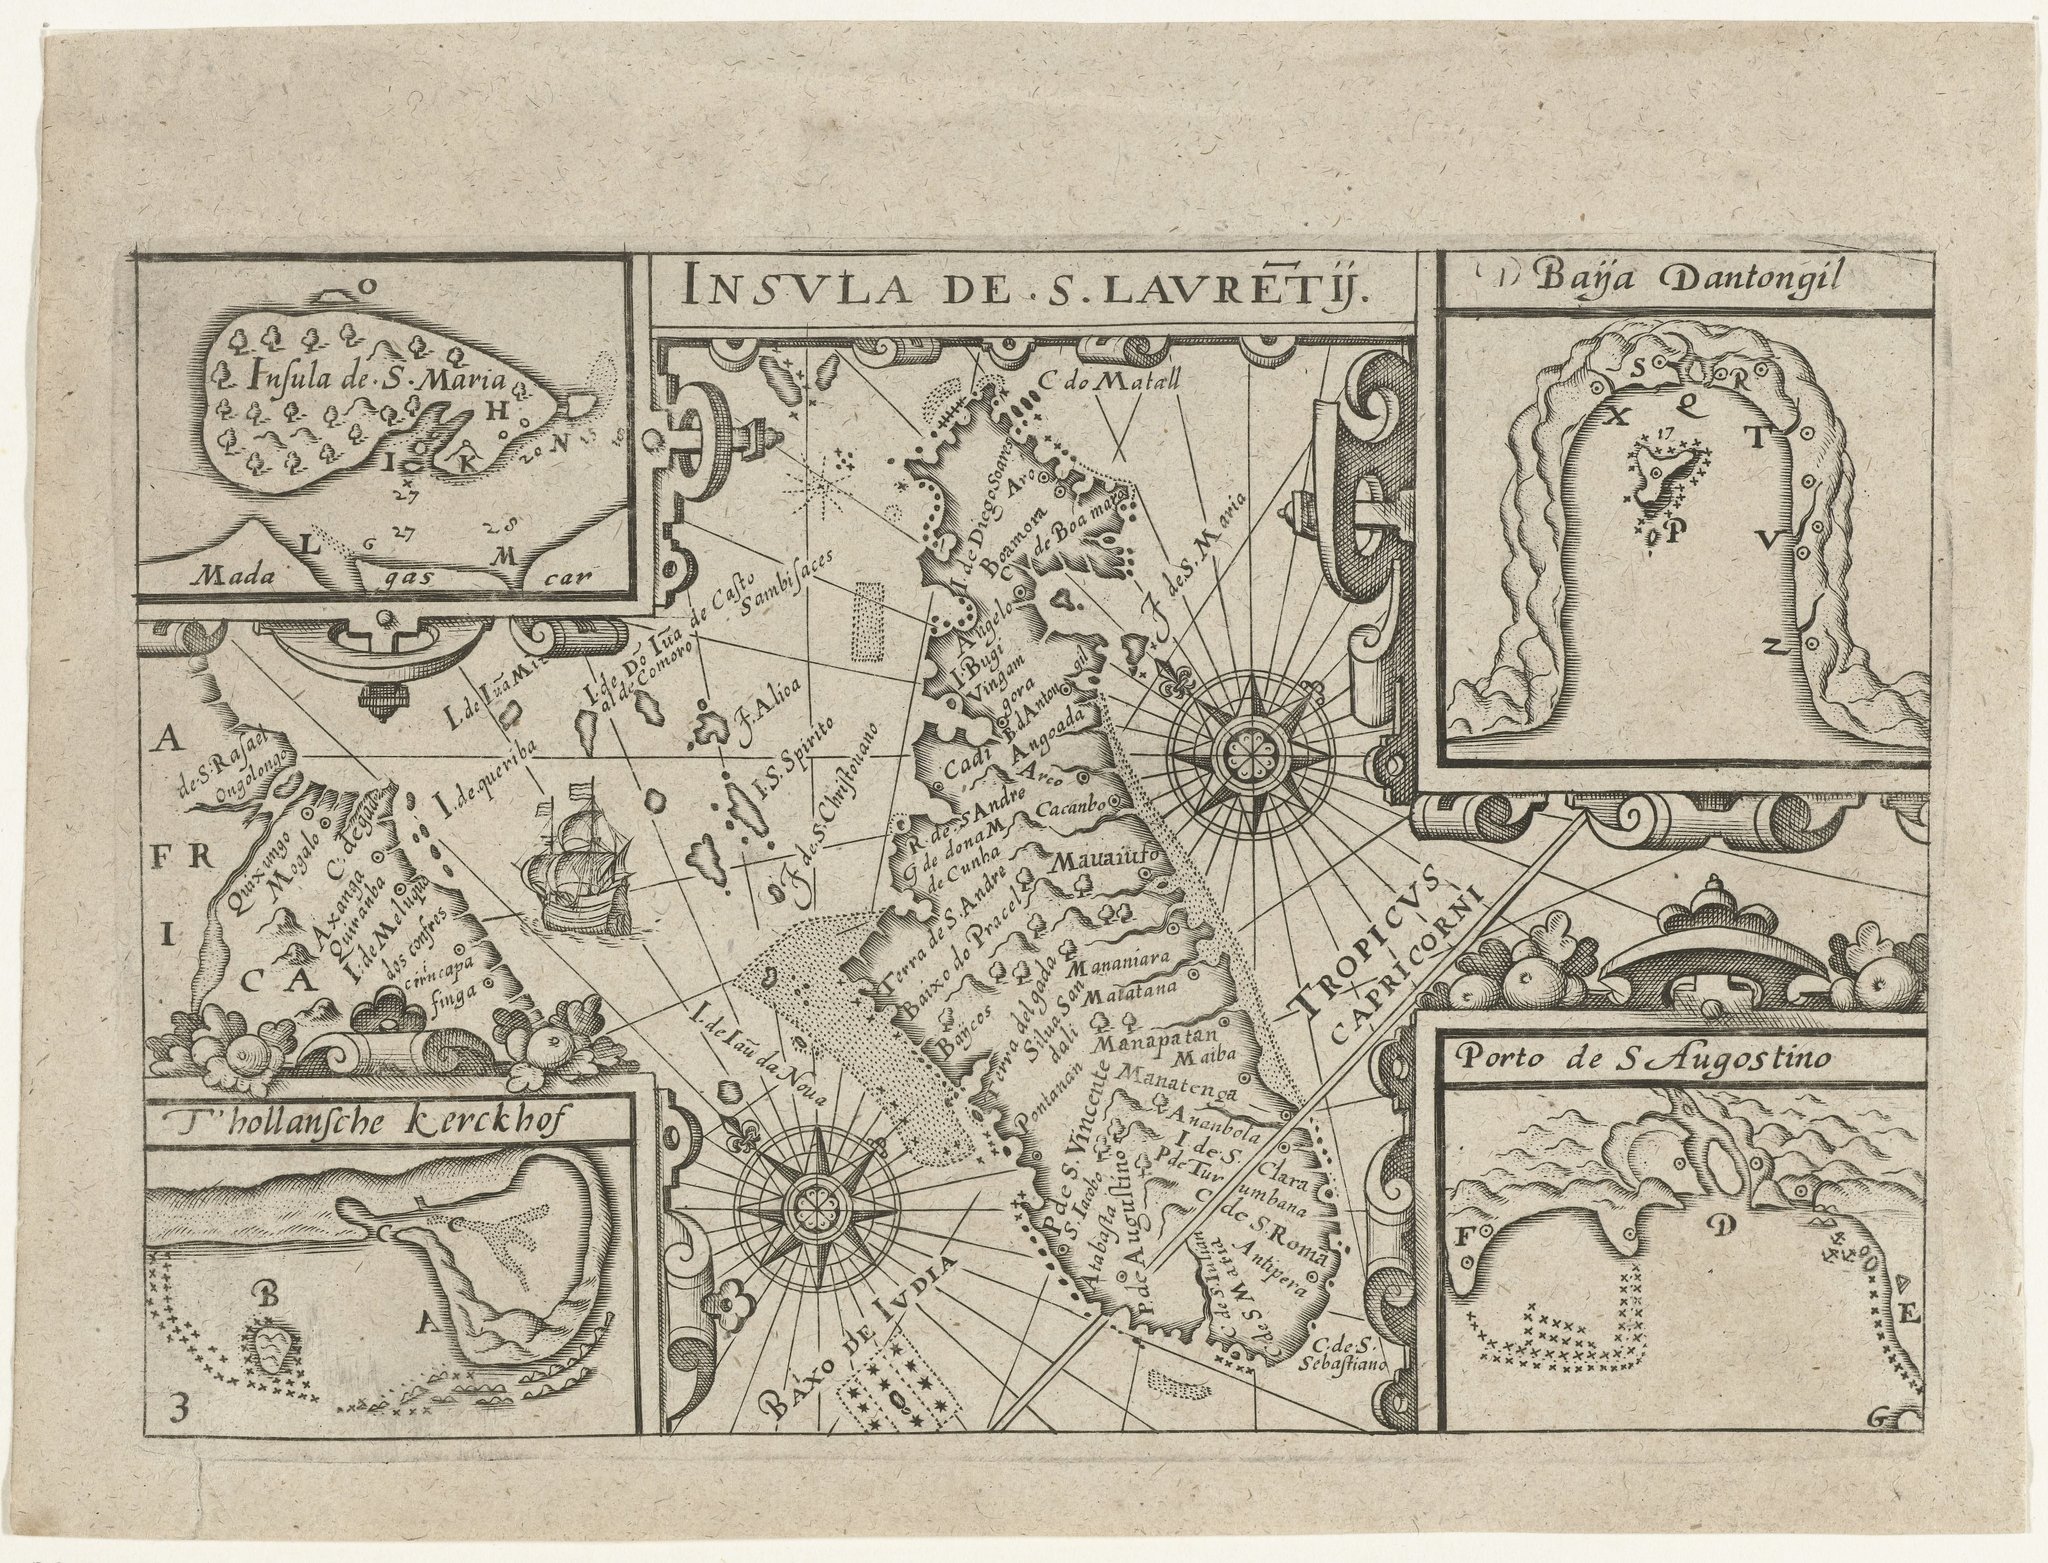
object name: map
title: Kaart van een deel van het eiland Madagaskar, 1595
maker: Anonymous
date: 1597-1598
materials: paper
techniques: engraving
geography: northern netherlands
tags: maps of separate countries or regions, landscapes in tropical and sub-tropical regions, exploration, expedition, voyage of discovery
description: Gebruikt als illustratie eerst in: Willem Lodewijcksz, D'eerste boeck. Historie van Indien, waer inne verhaelt is de avontueren die de Hollandtsche schepen bejeghent zijn, Cornelis Claes, Amsterdam 1598. In deze opgewerkte staat gebruikt in: De Eerste Schipvaerd der Hollandsche Natie naer Oost-Indien, waer inne verhaelt wordt al wat haer sonderlings onder wegen bejegent is ... ghetrocken uyt verscheyden Iournalen ofte dagh-registers daer van ghemaeckt, zeer vermaeckelijck ende nut om lesen. Opgenomen in: I. Commelin, Begin ende voortgangh, van de Vereenighde Nederlantsche Geoctroyeerde Oost-Indische Compagnie, J. Janssonius, Amsterdam 1646. Genummerd: 3.